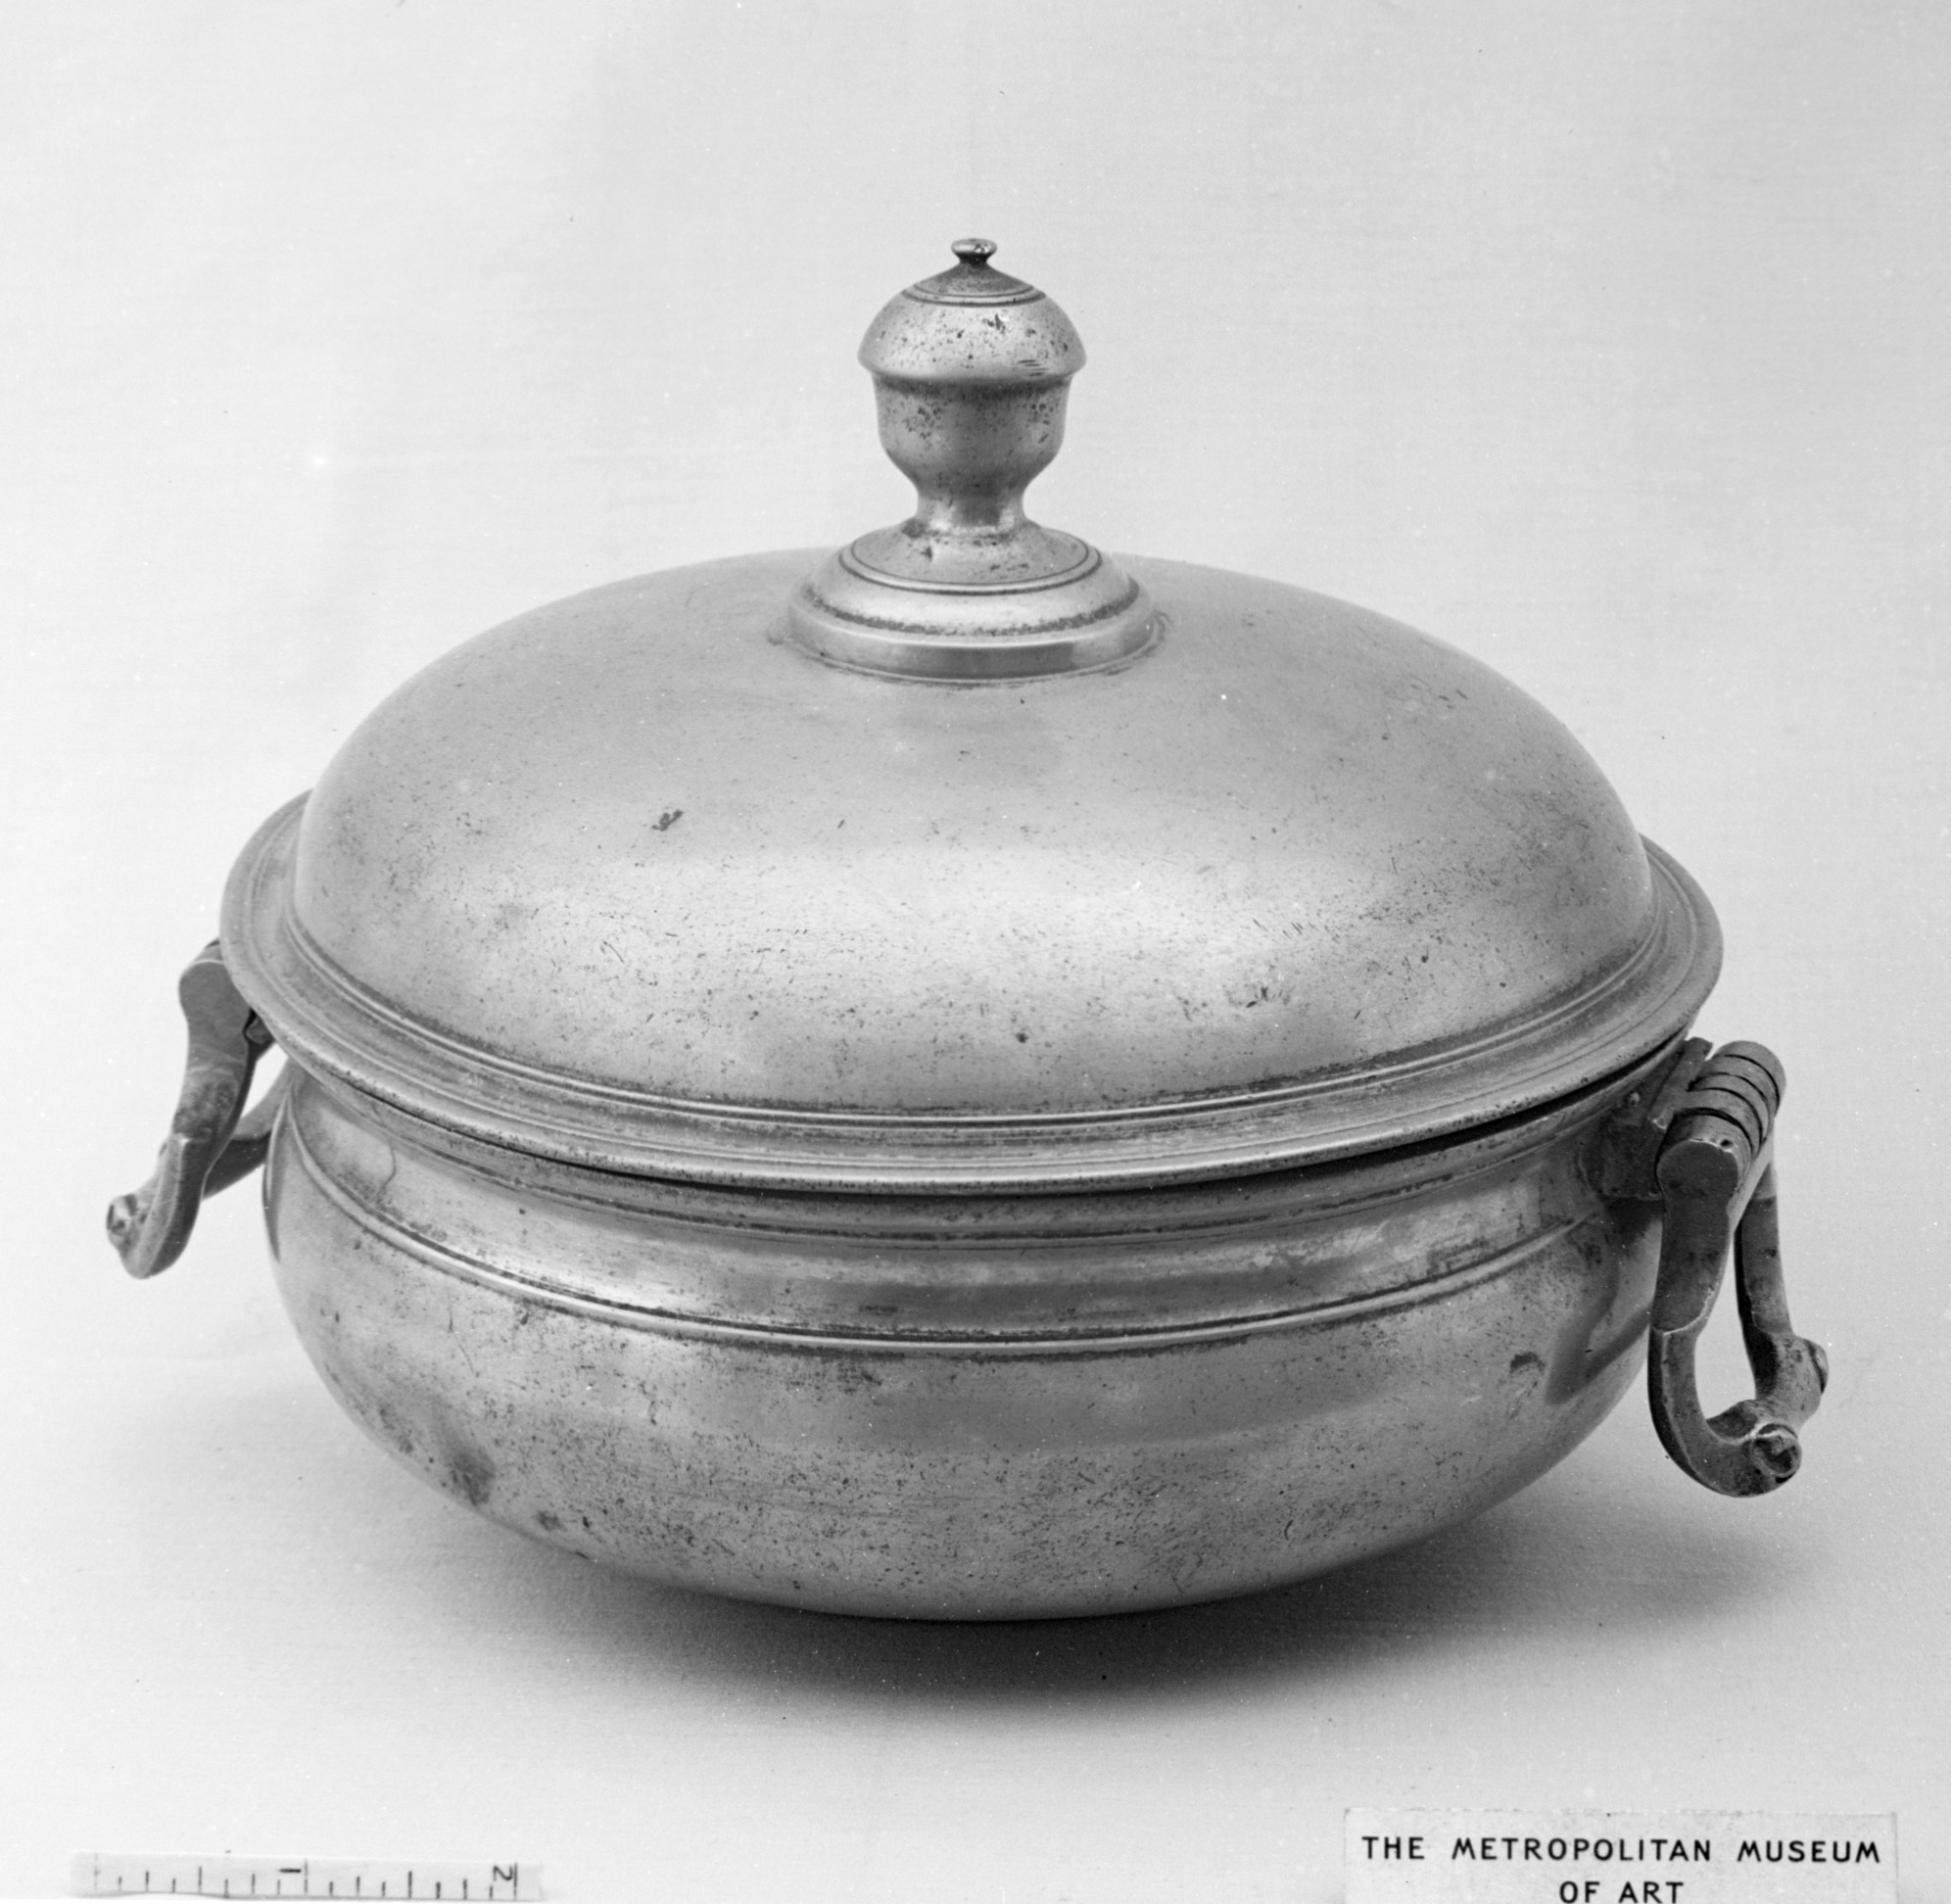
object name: dish with cover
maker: johan gustaf ryman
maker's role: maker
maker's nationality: swedish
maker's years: 1761-1797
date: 1775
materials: pewter